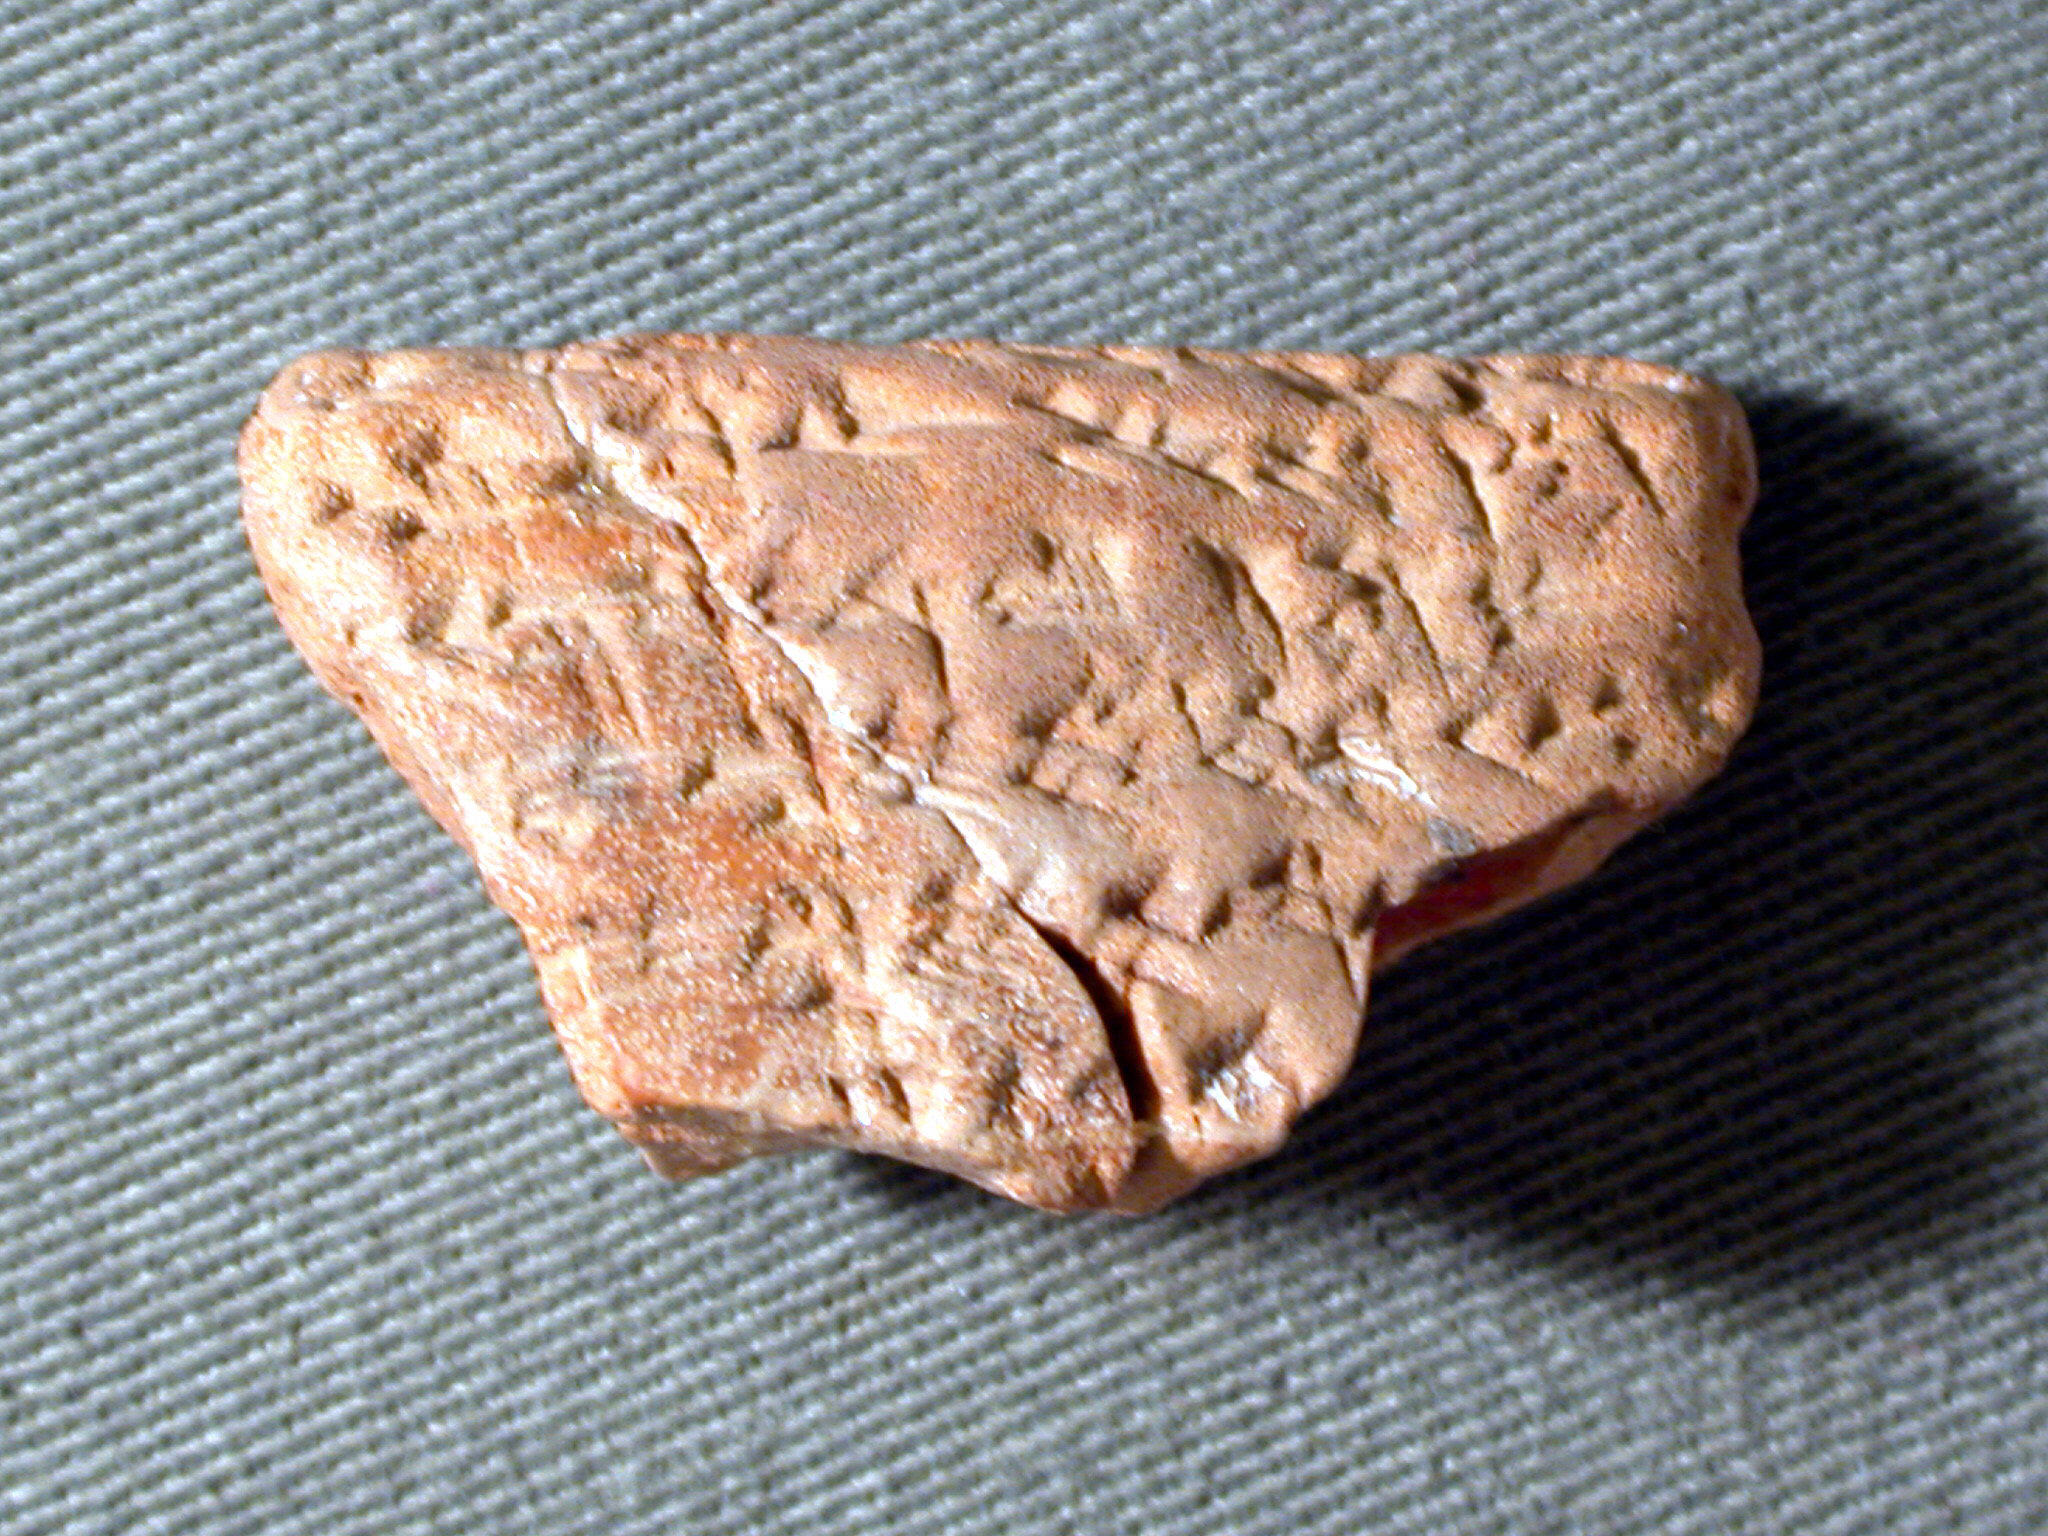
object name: cuneiform tablet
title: Cuneiform tablet: fragment of a field lease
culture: achaemenid or babylonian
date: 700-301 BCE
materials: clay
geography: mesopotamia